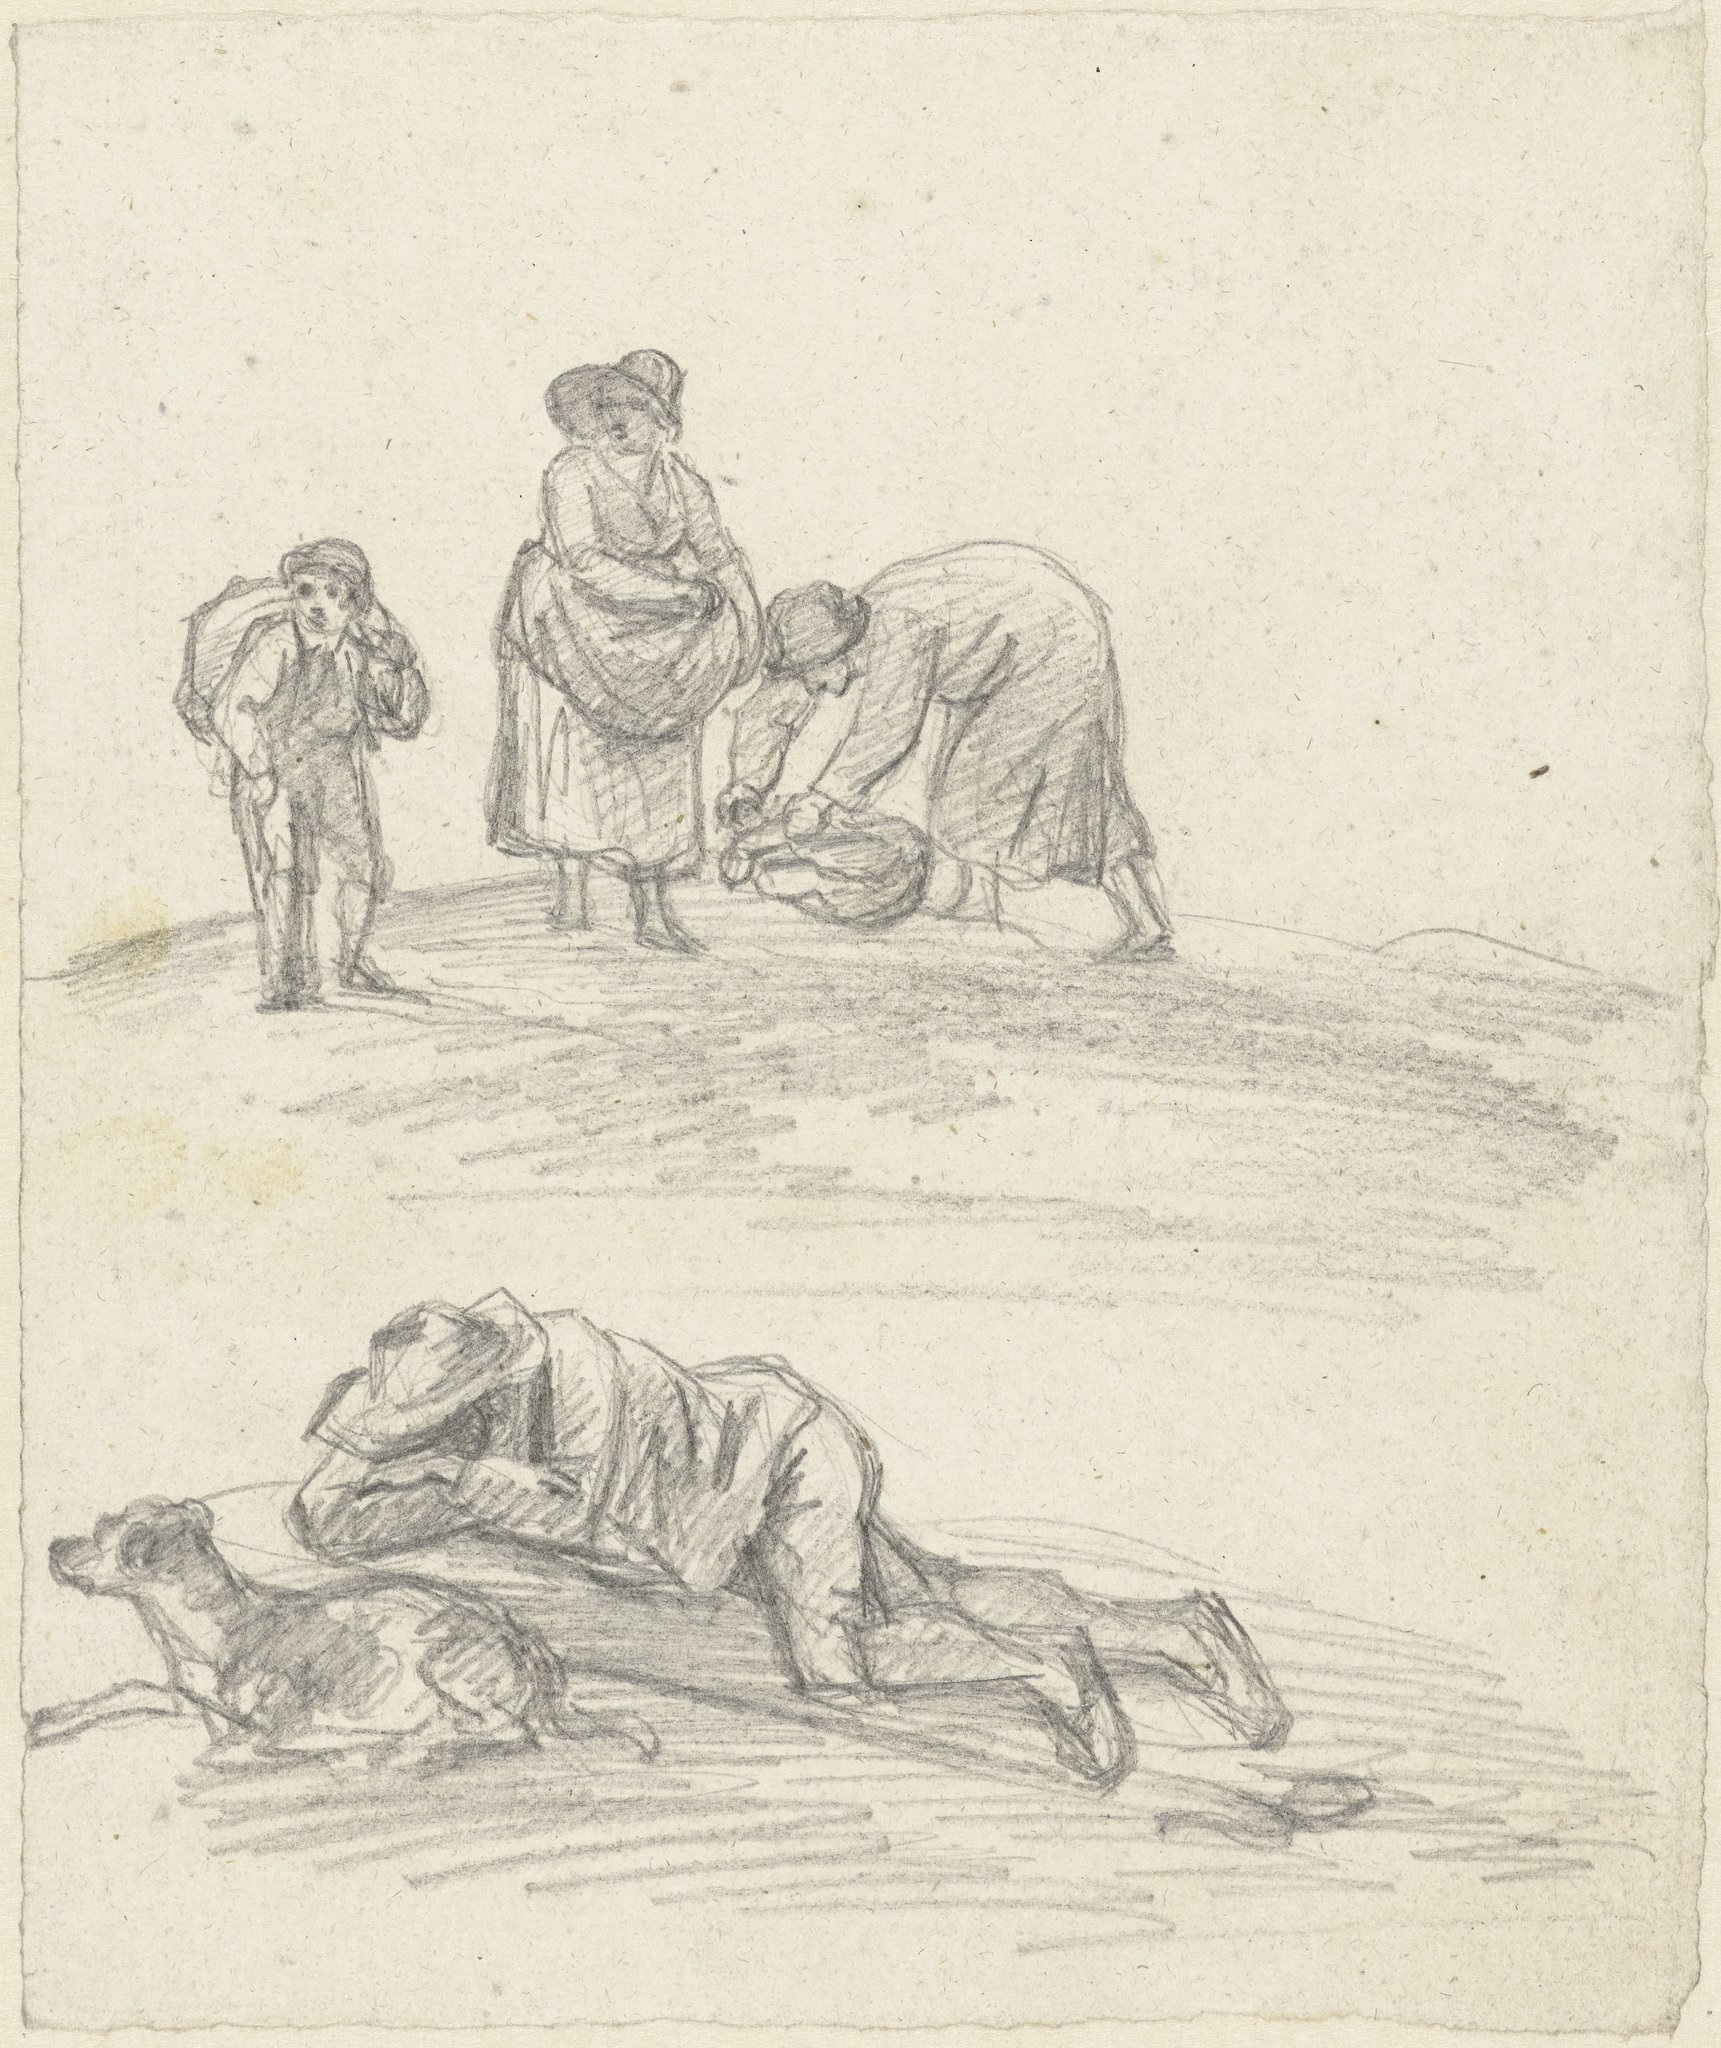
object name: drawing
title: Twee schetsen van twee vrouwen met een kind en een liggende man met een hond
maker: simon andreas krausz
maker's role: draughtsman, print maker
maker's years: 1760-1825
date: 1770-1825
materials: paper, pencil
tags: dog